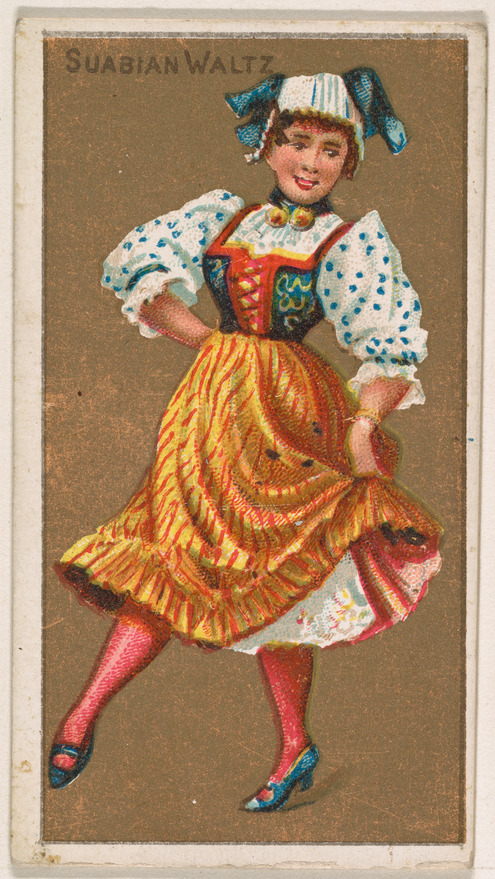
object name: print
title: Suabian Dance, from National Dances (N225, Type 1) issued by Kinney Bros.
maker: kinney brothers tobacco company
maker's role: publisher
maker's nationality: american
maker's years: 1869-2011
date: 1889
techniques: color lithograph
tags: women,dancing